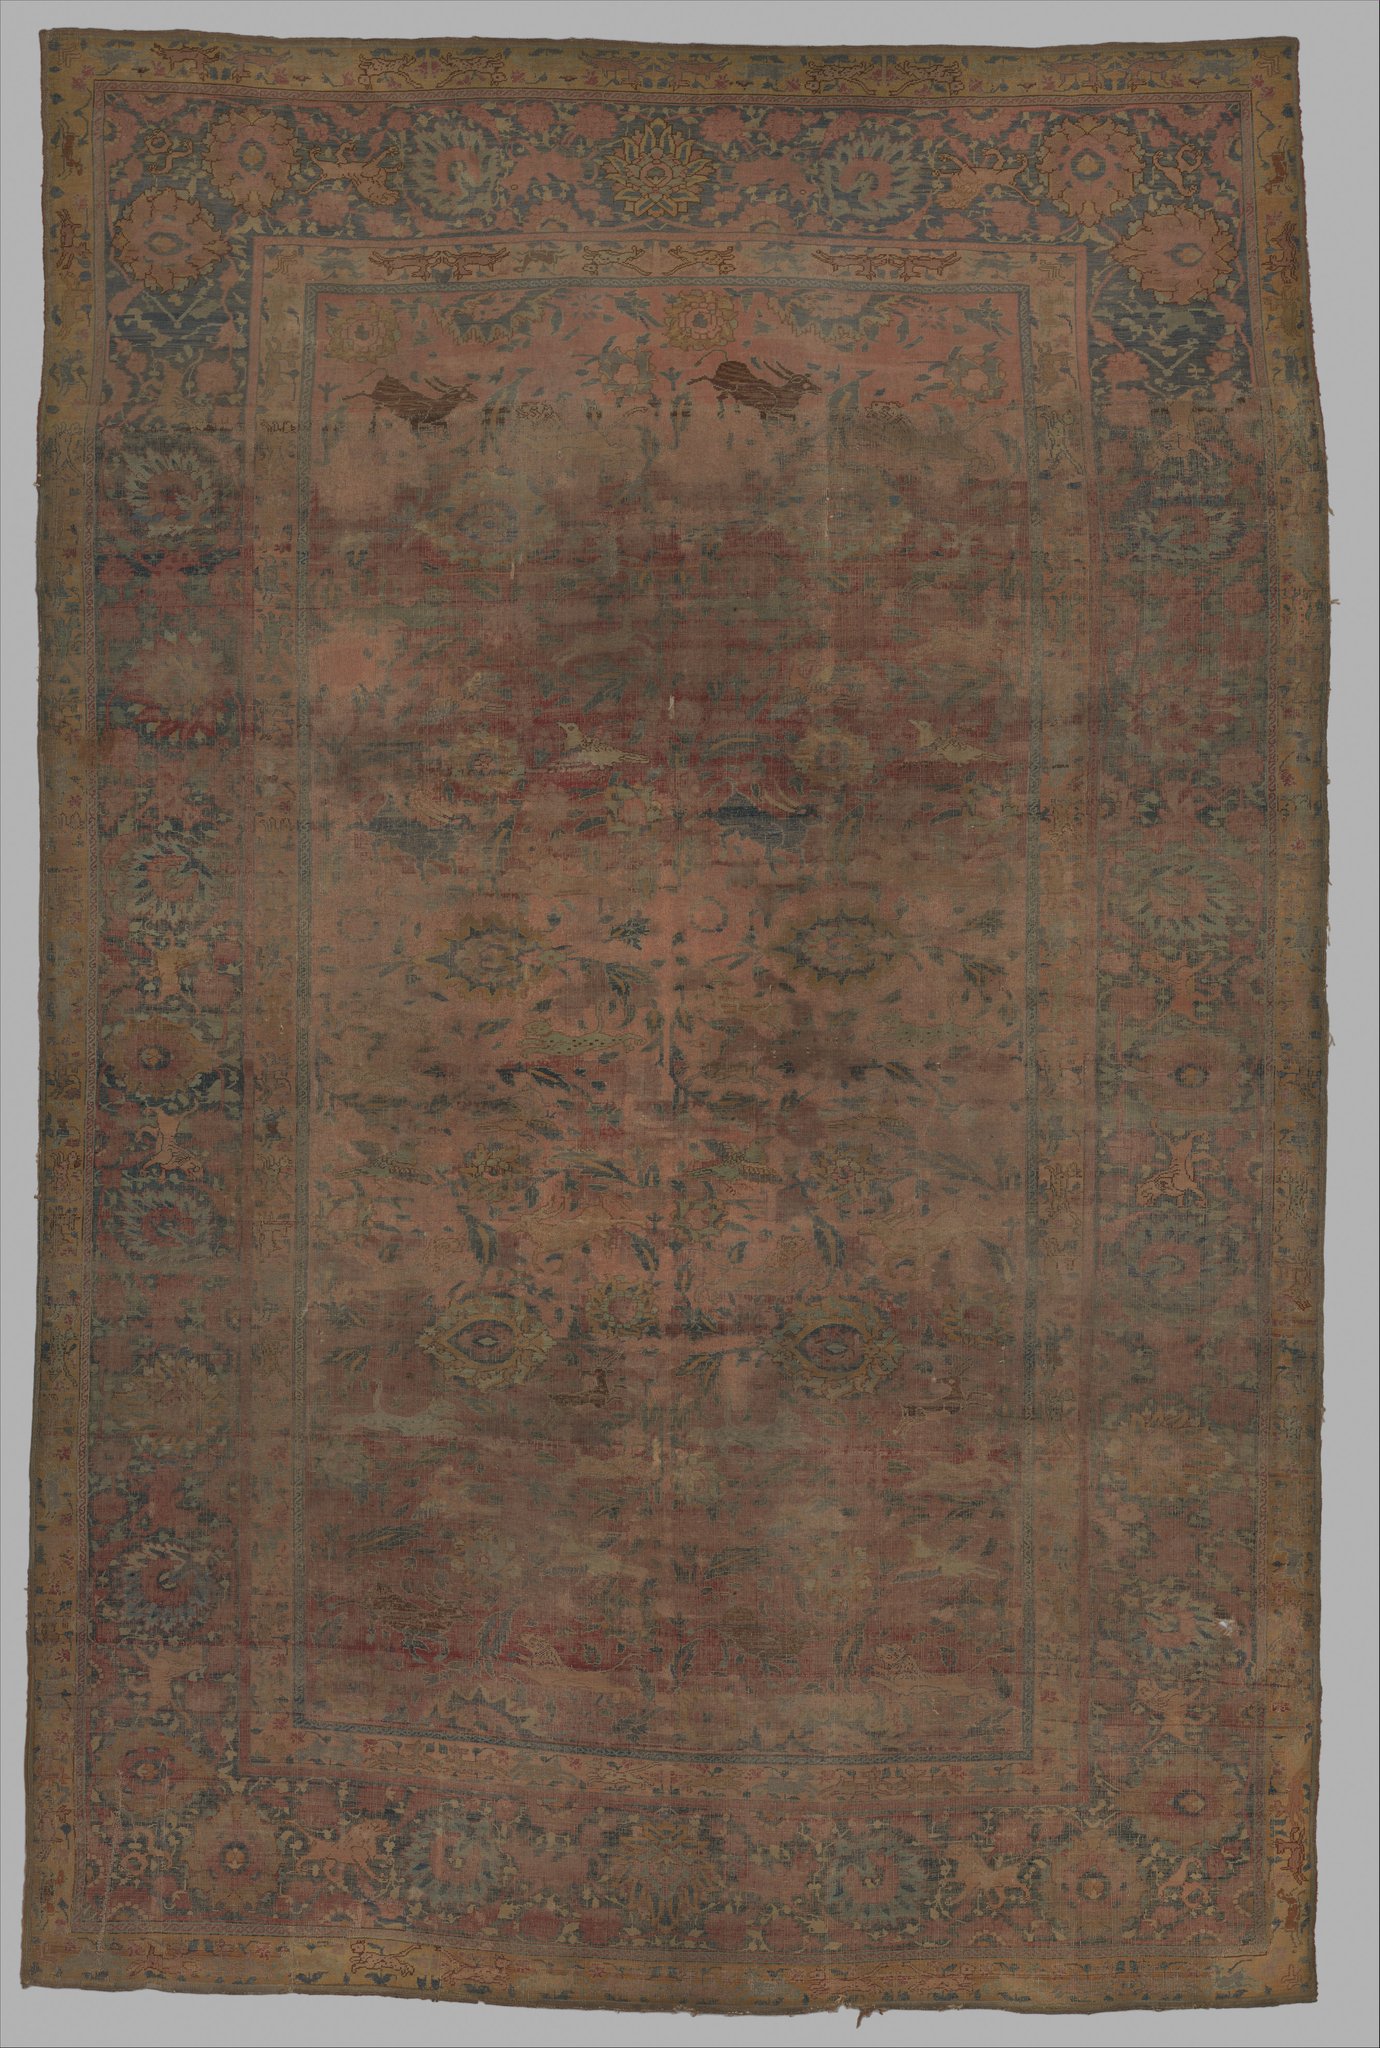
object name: carpet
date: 1701-1800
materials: wool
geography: india